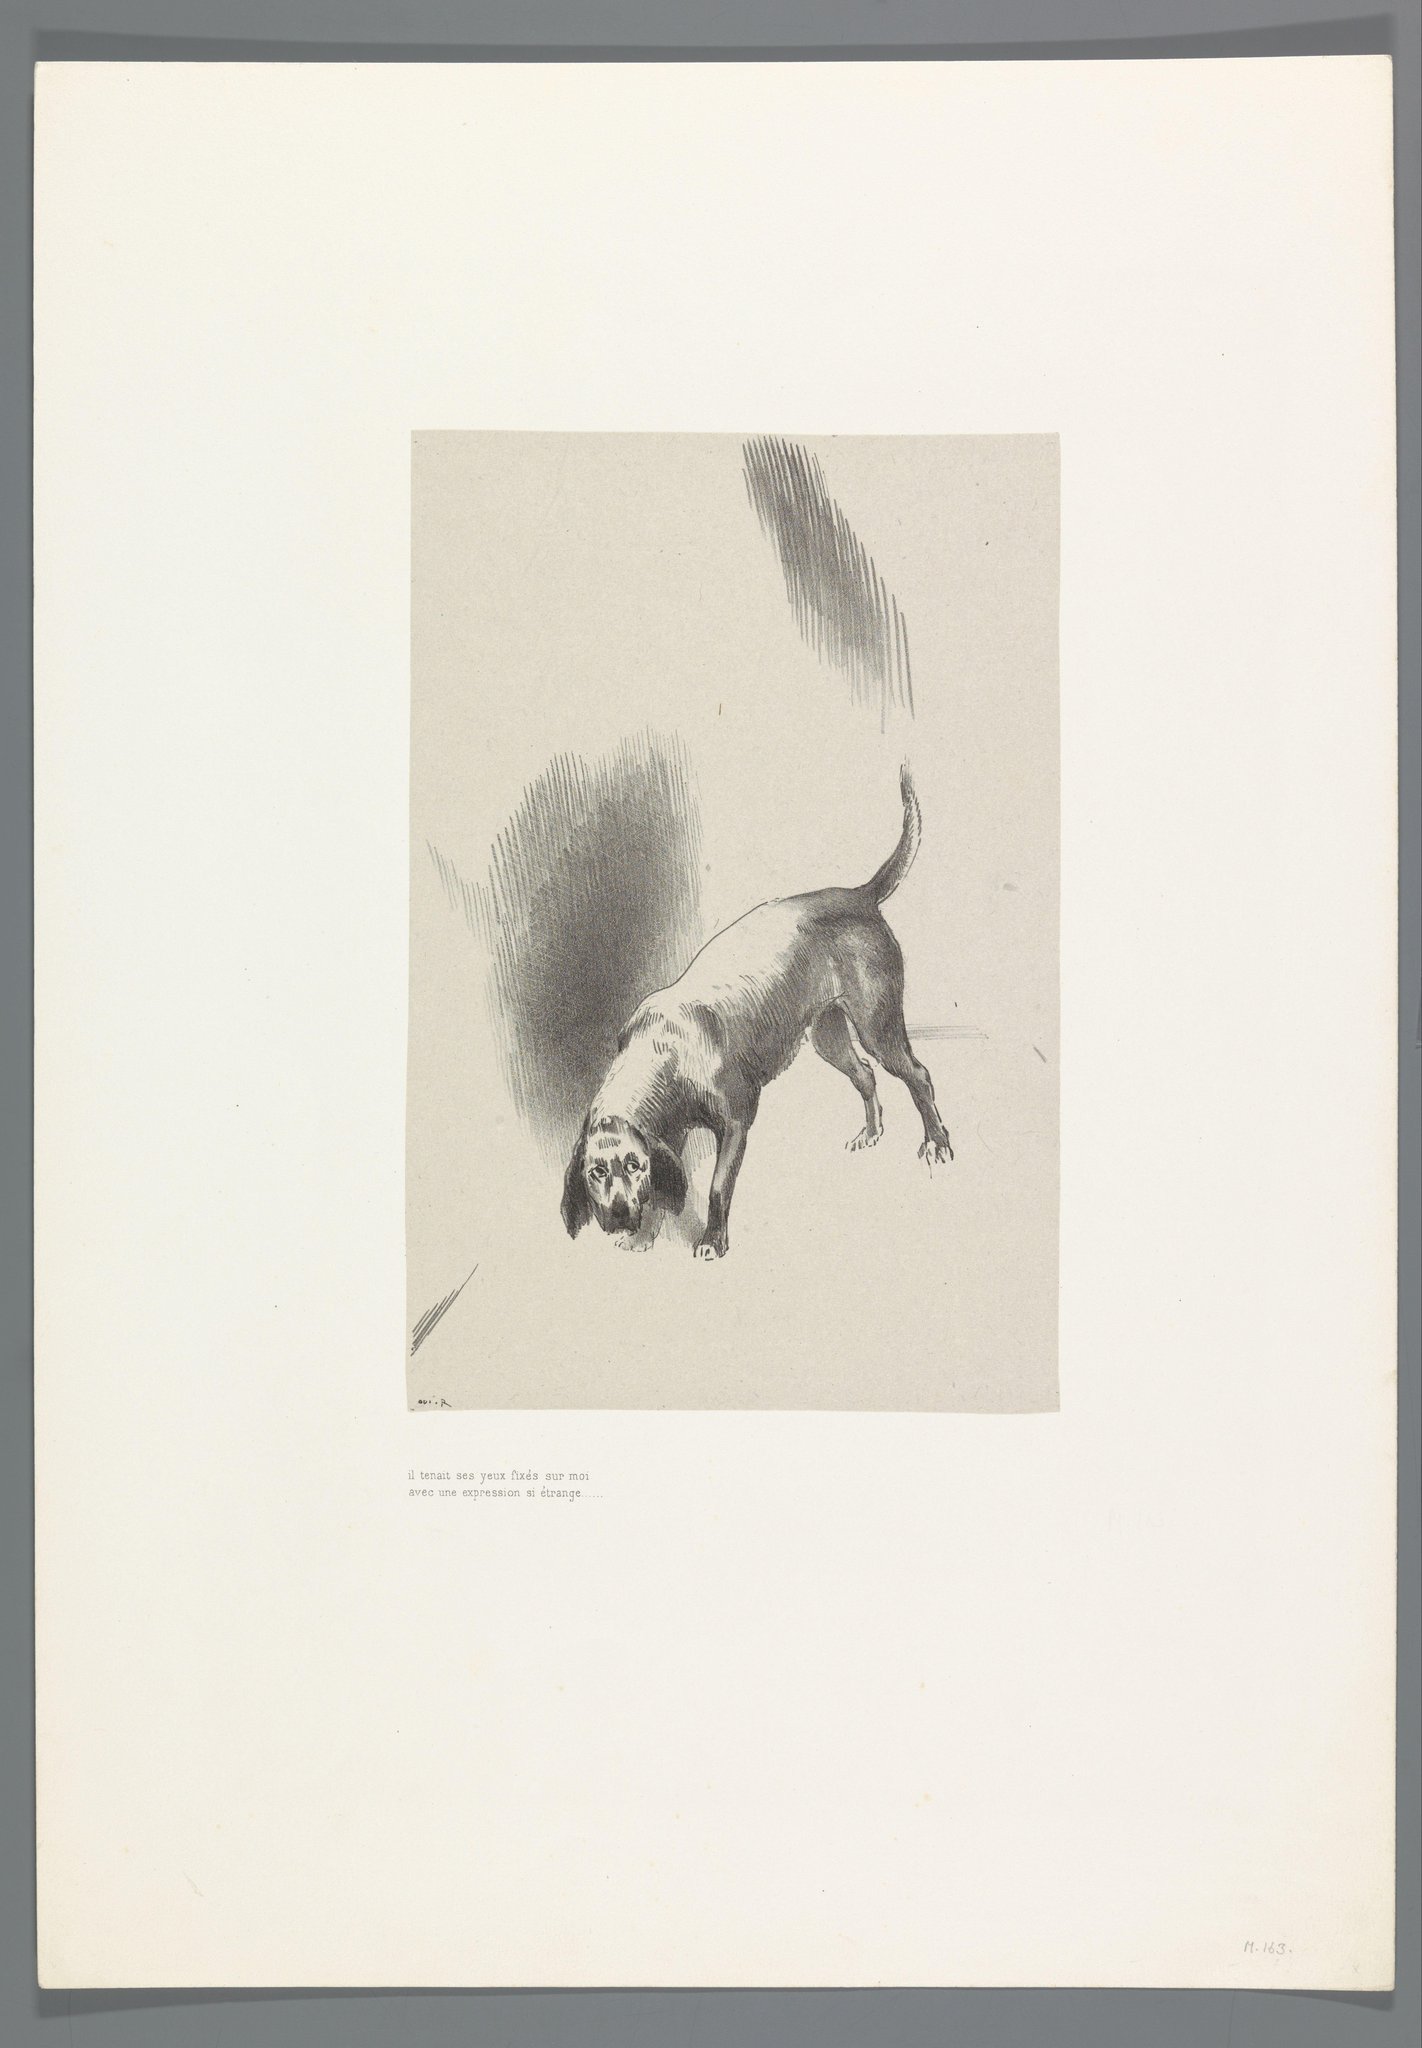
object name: print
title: La Maison Hautée, 6 litho's omslag titelblad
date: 1896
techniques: printmaking, lithograph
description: Hij hield zijn ogen op mij gericht met een dusdanig vreemde blik